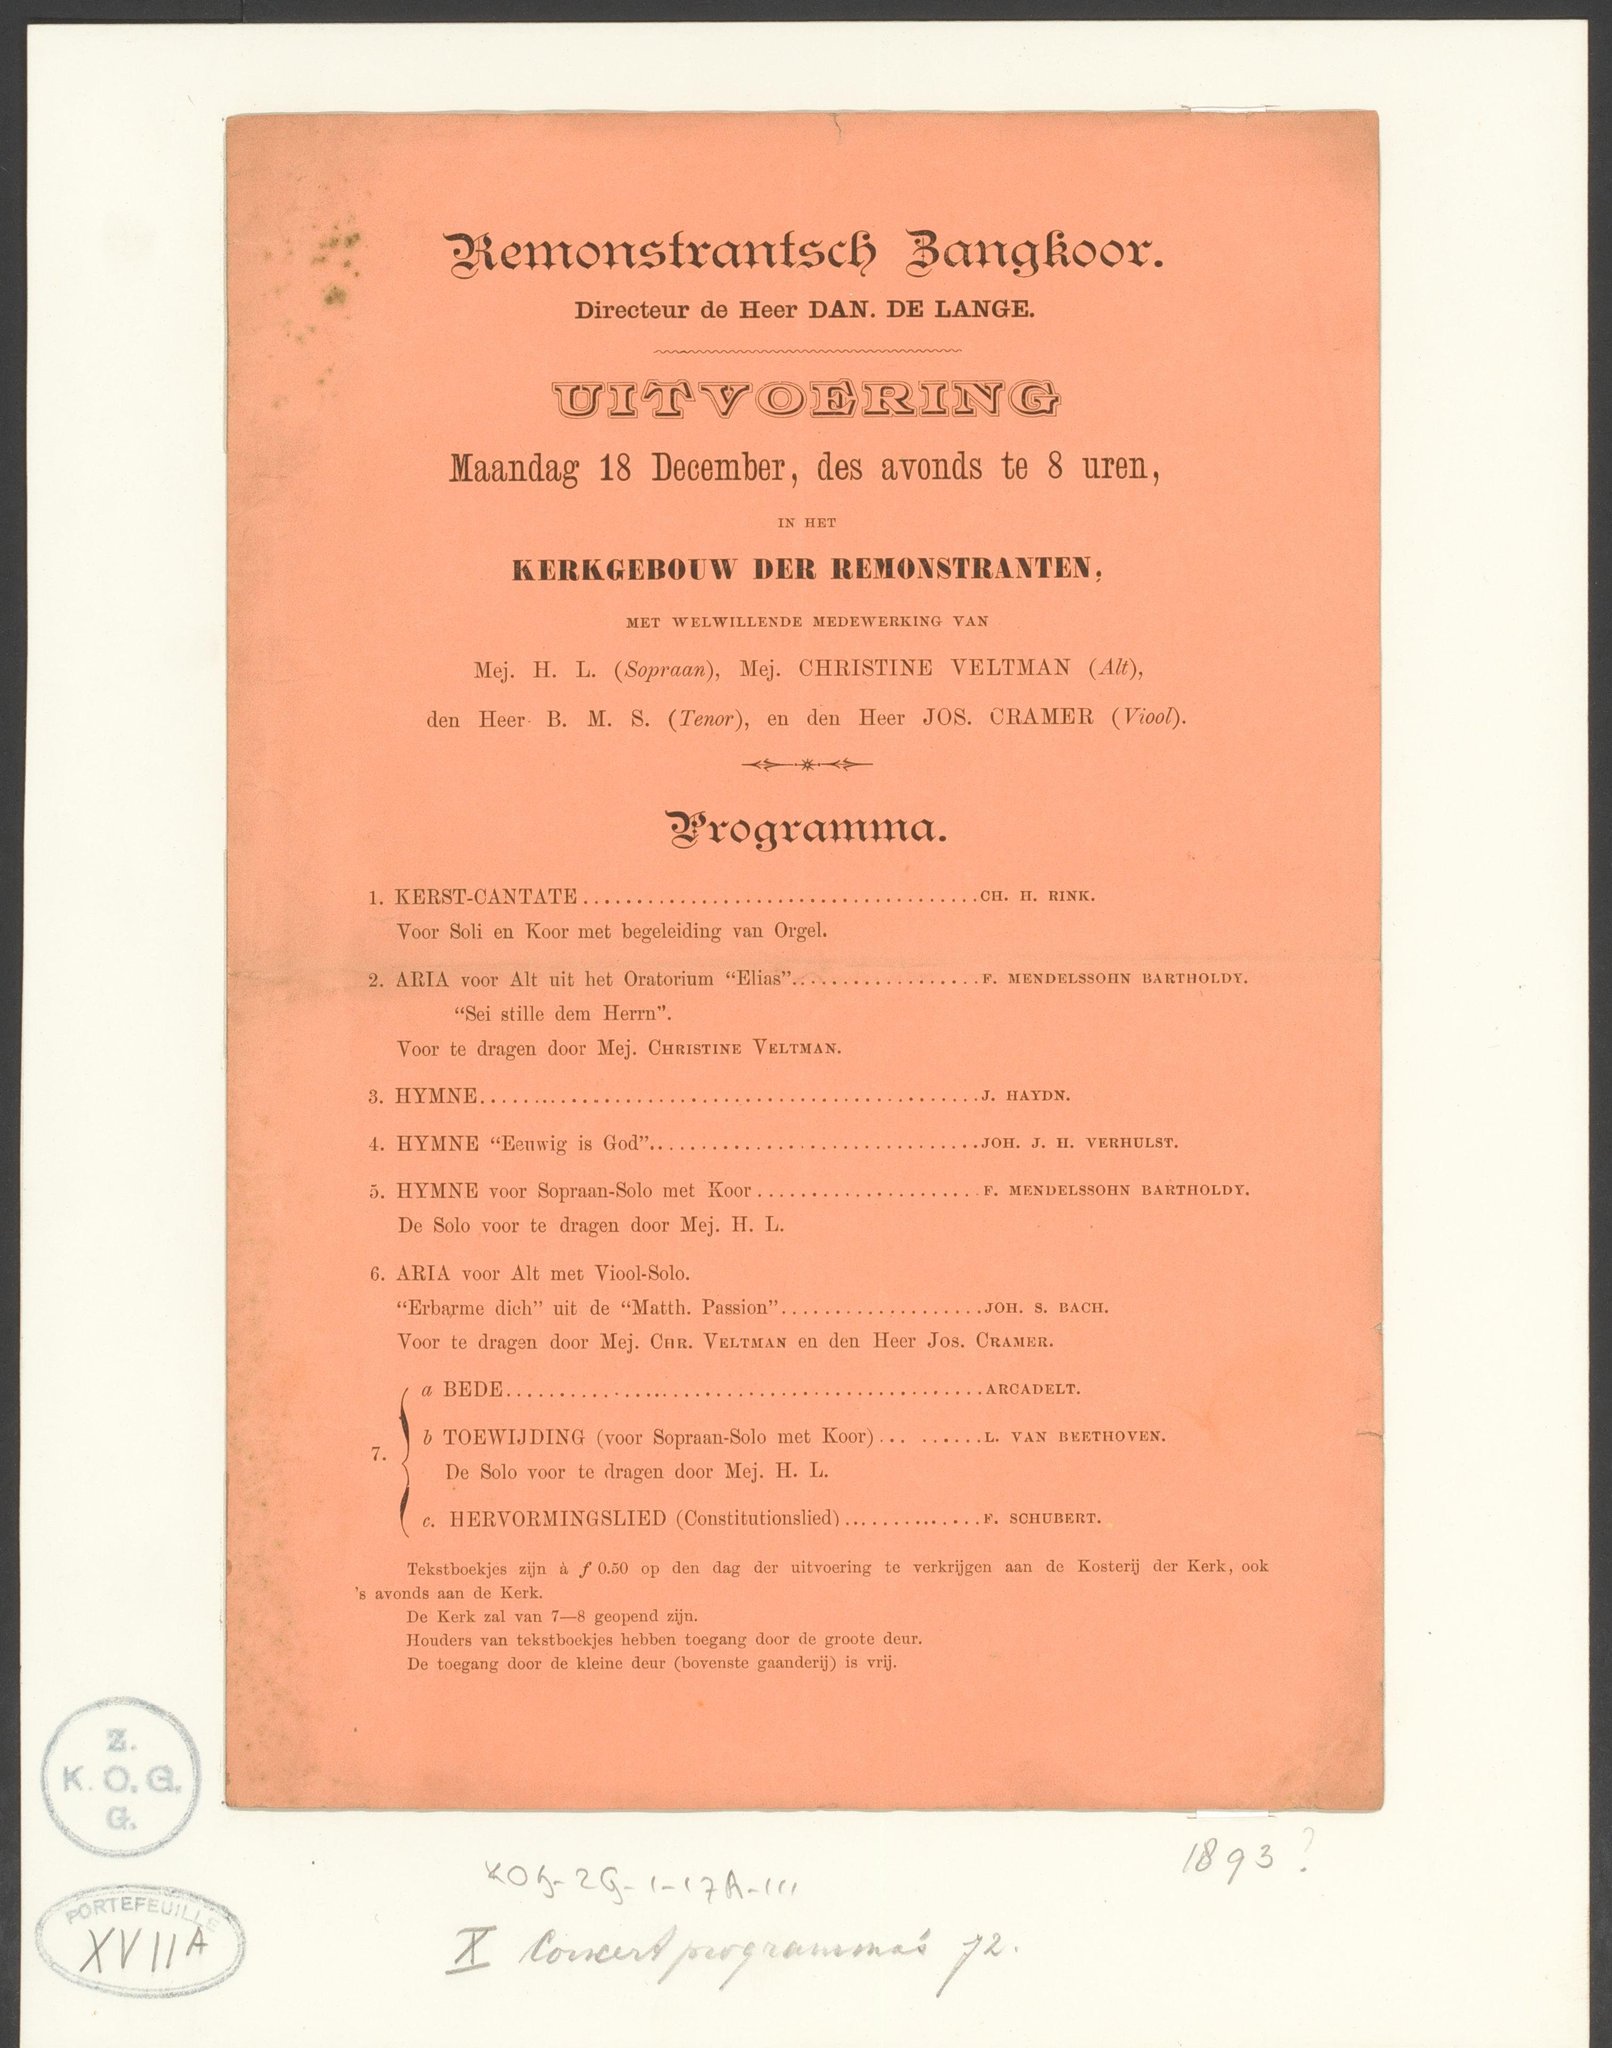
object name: text sheet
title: Programma voor een uitvoering van het Remonstrantsch Zangkoor op 18 december (1893?)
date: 1893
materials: paper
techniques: letterpress printing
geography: amsterdam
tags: listening to music, large group of musicians, orchestra, choir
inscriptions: collector's mark: Lugt 1641, collector's mark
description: Gedrukt programma voor een uitvoering van het Remonstrantsch Zangkoor op 18 maart (1893?), in het 'Kerkgebouw der Remonstanten' te Amsterdam. Dubbelgevouwen omslag van oranje papier met binnenin bladen met de teksten van de zangstukken. Onderwerpsrubrieken binnen de Atlas Zeden en Gewoonten: Muziek en muziekinstrumenten: Varia.